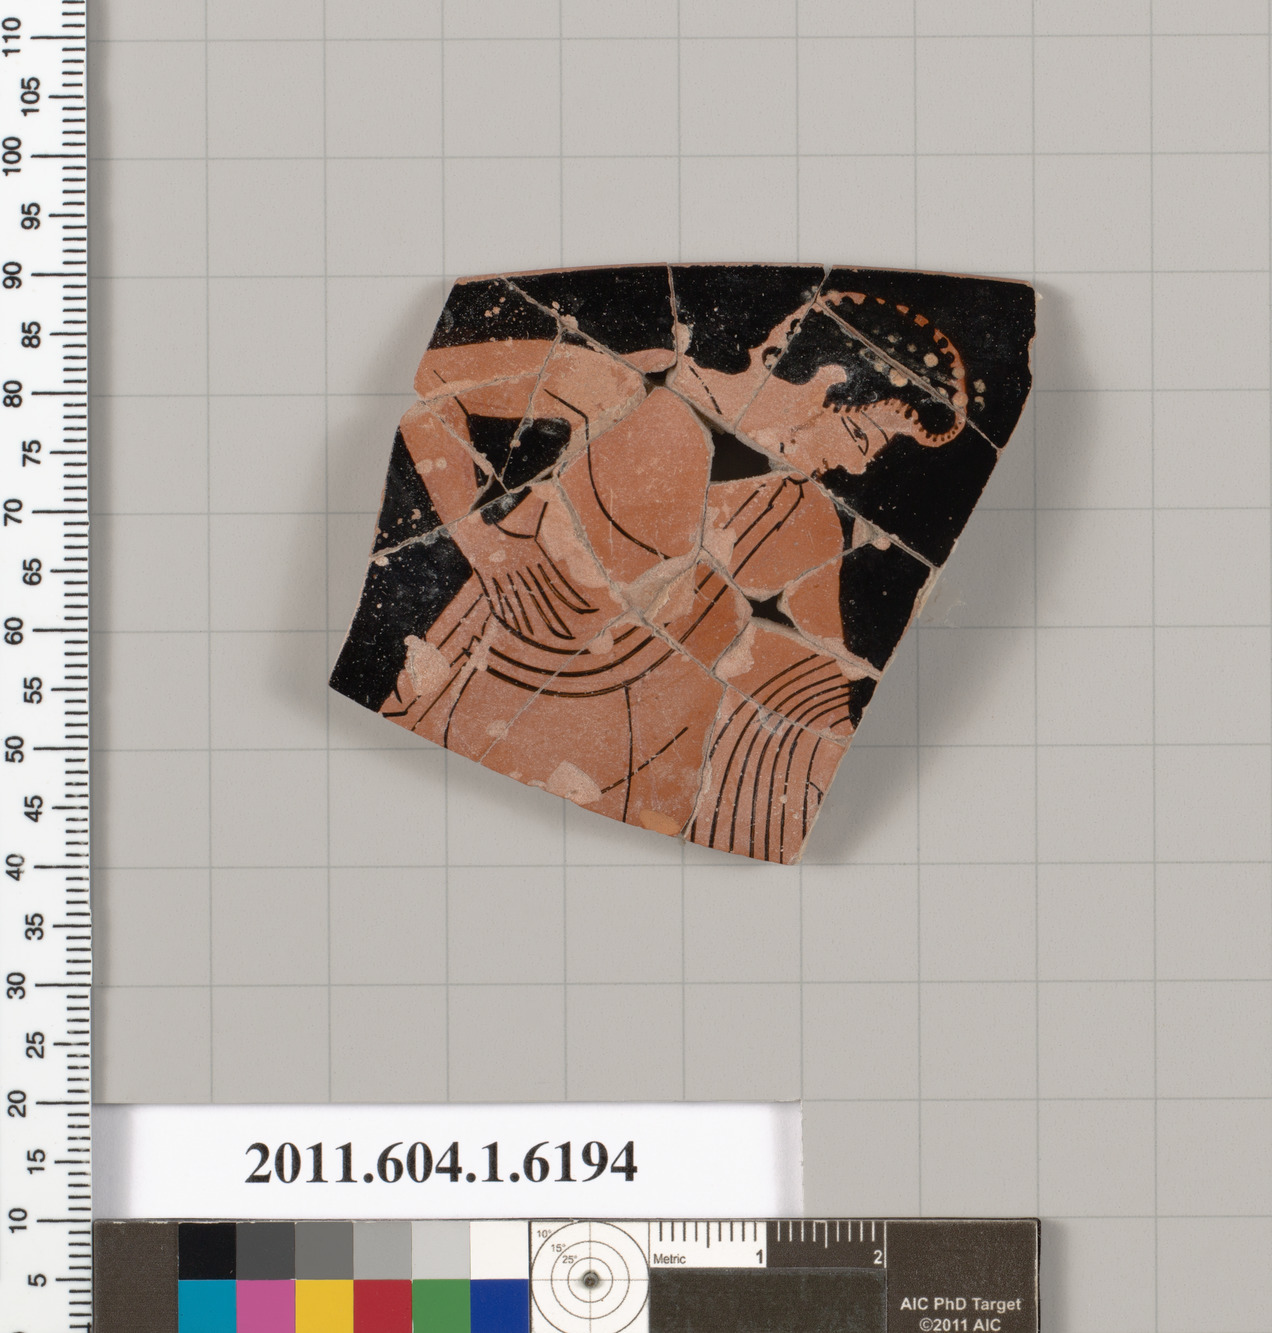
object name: kylix fragment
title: Terracotta rim fragment of a kylix (drinking cup)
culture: greek, attic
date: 510-500 BCE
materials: terracotta